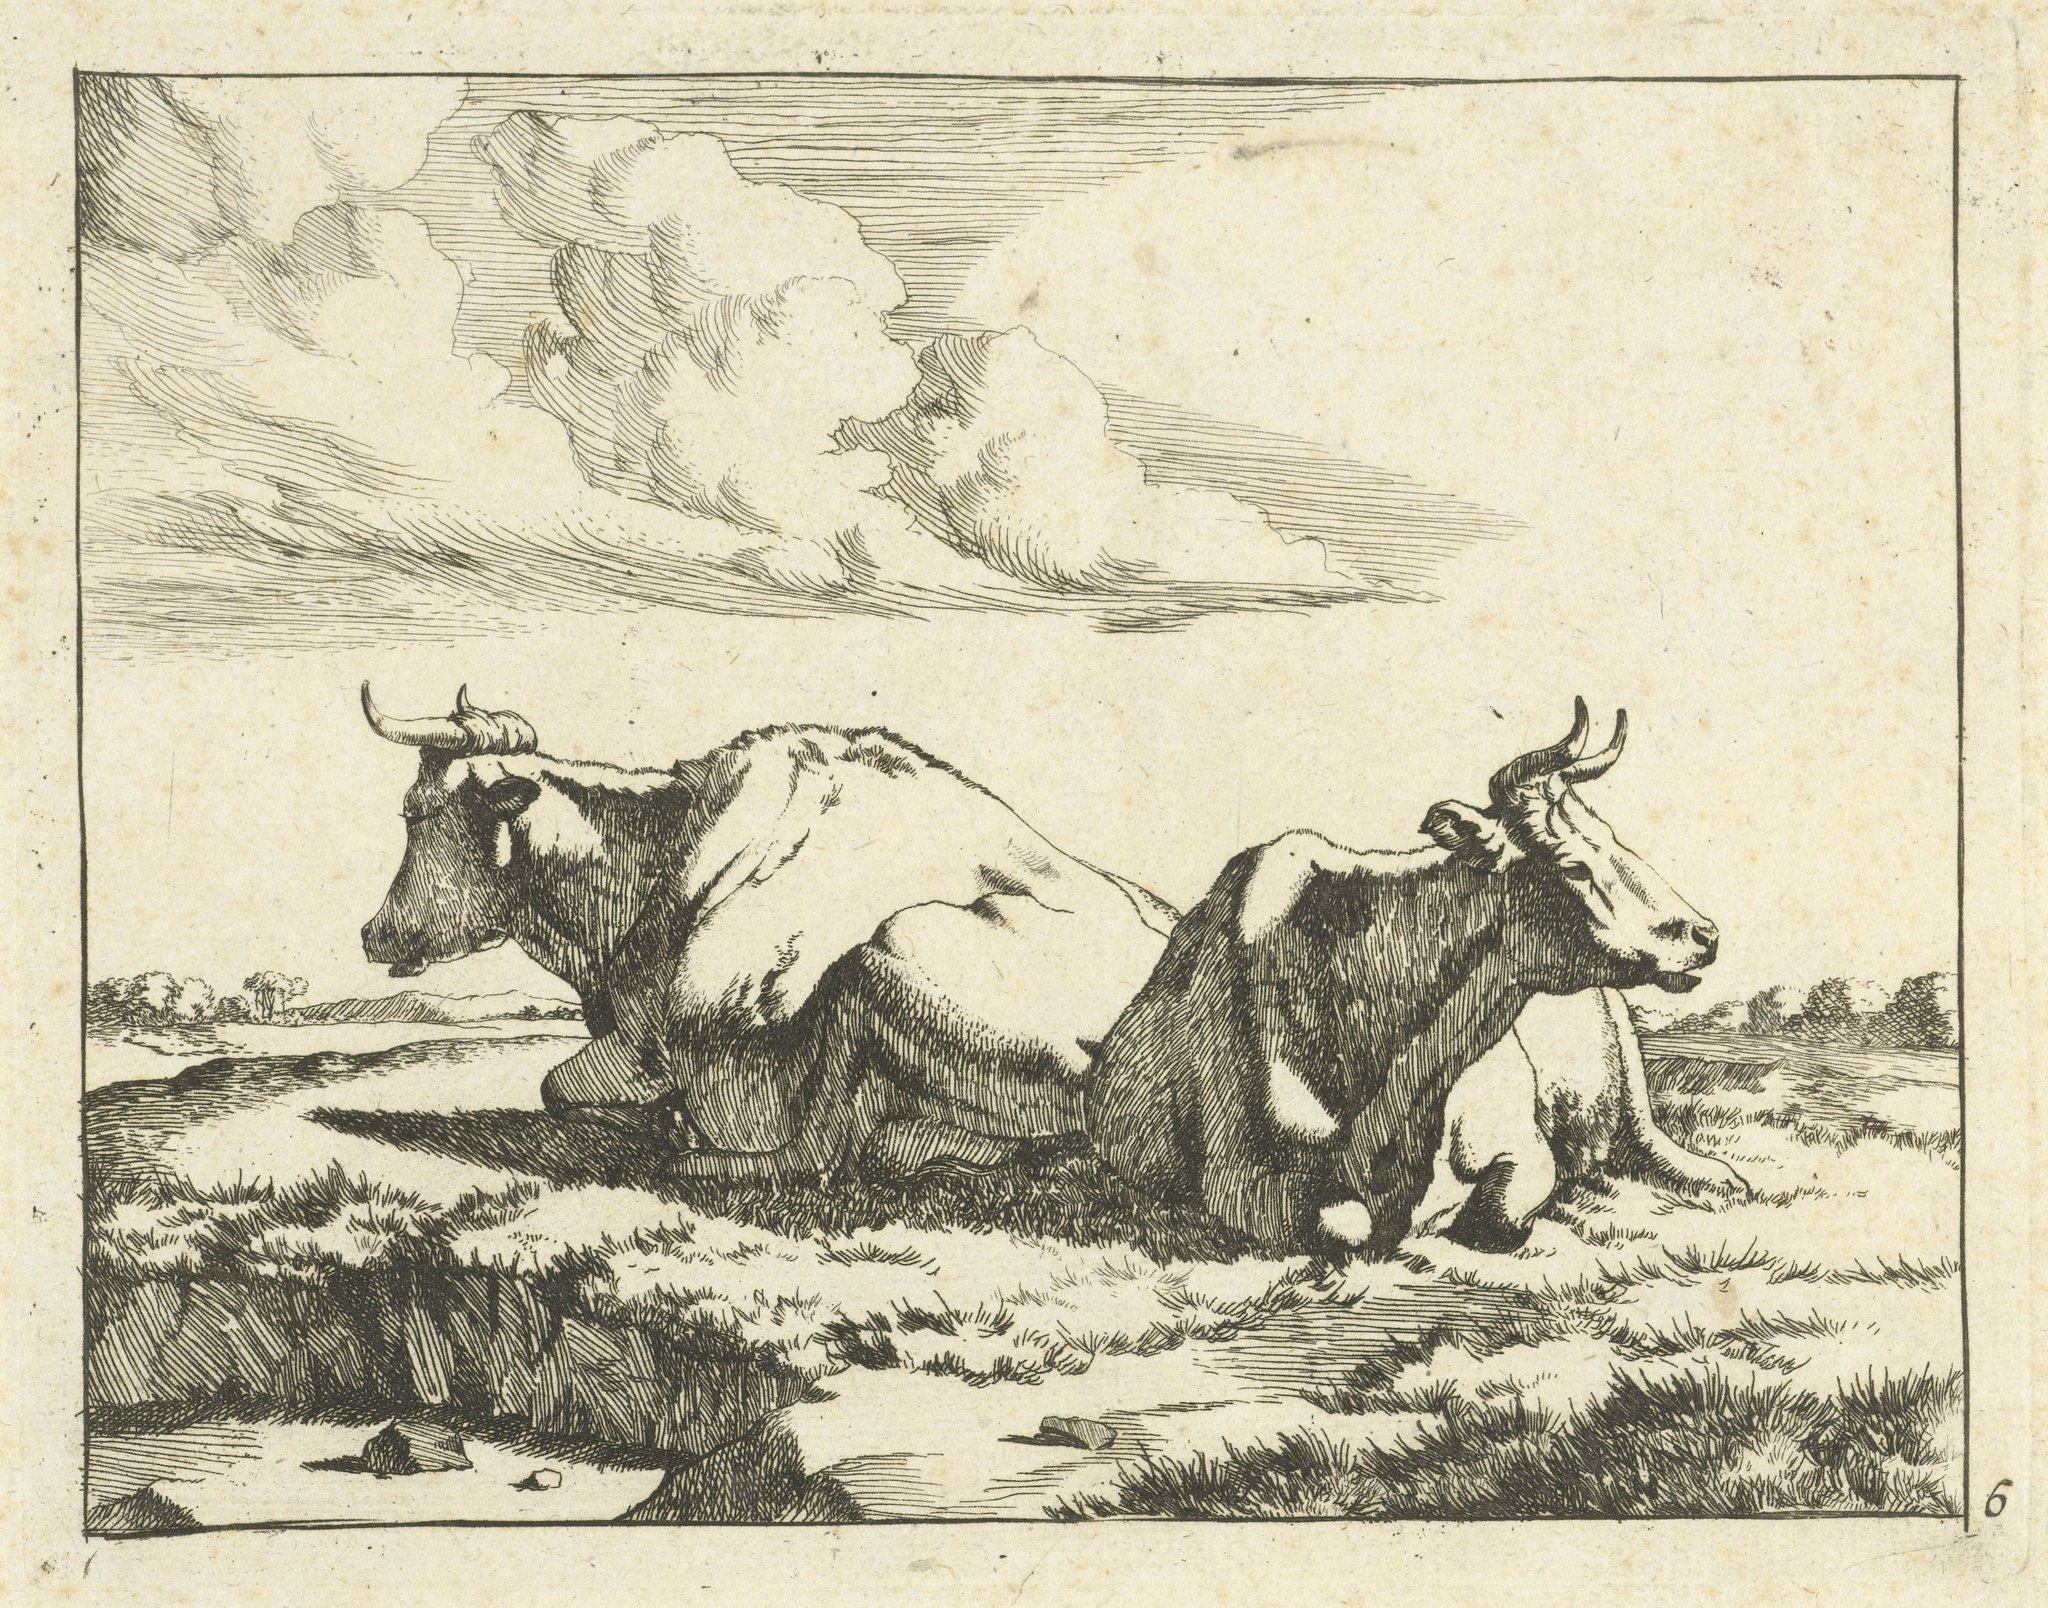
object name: print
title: Twee liggende koeien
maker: marcus de bye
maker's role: print maker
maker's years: 1639-1688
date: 1657-1677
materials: paper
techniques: etching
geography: the hague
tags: cow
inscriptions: collector's mark: Lugt 2228